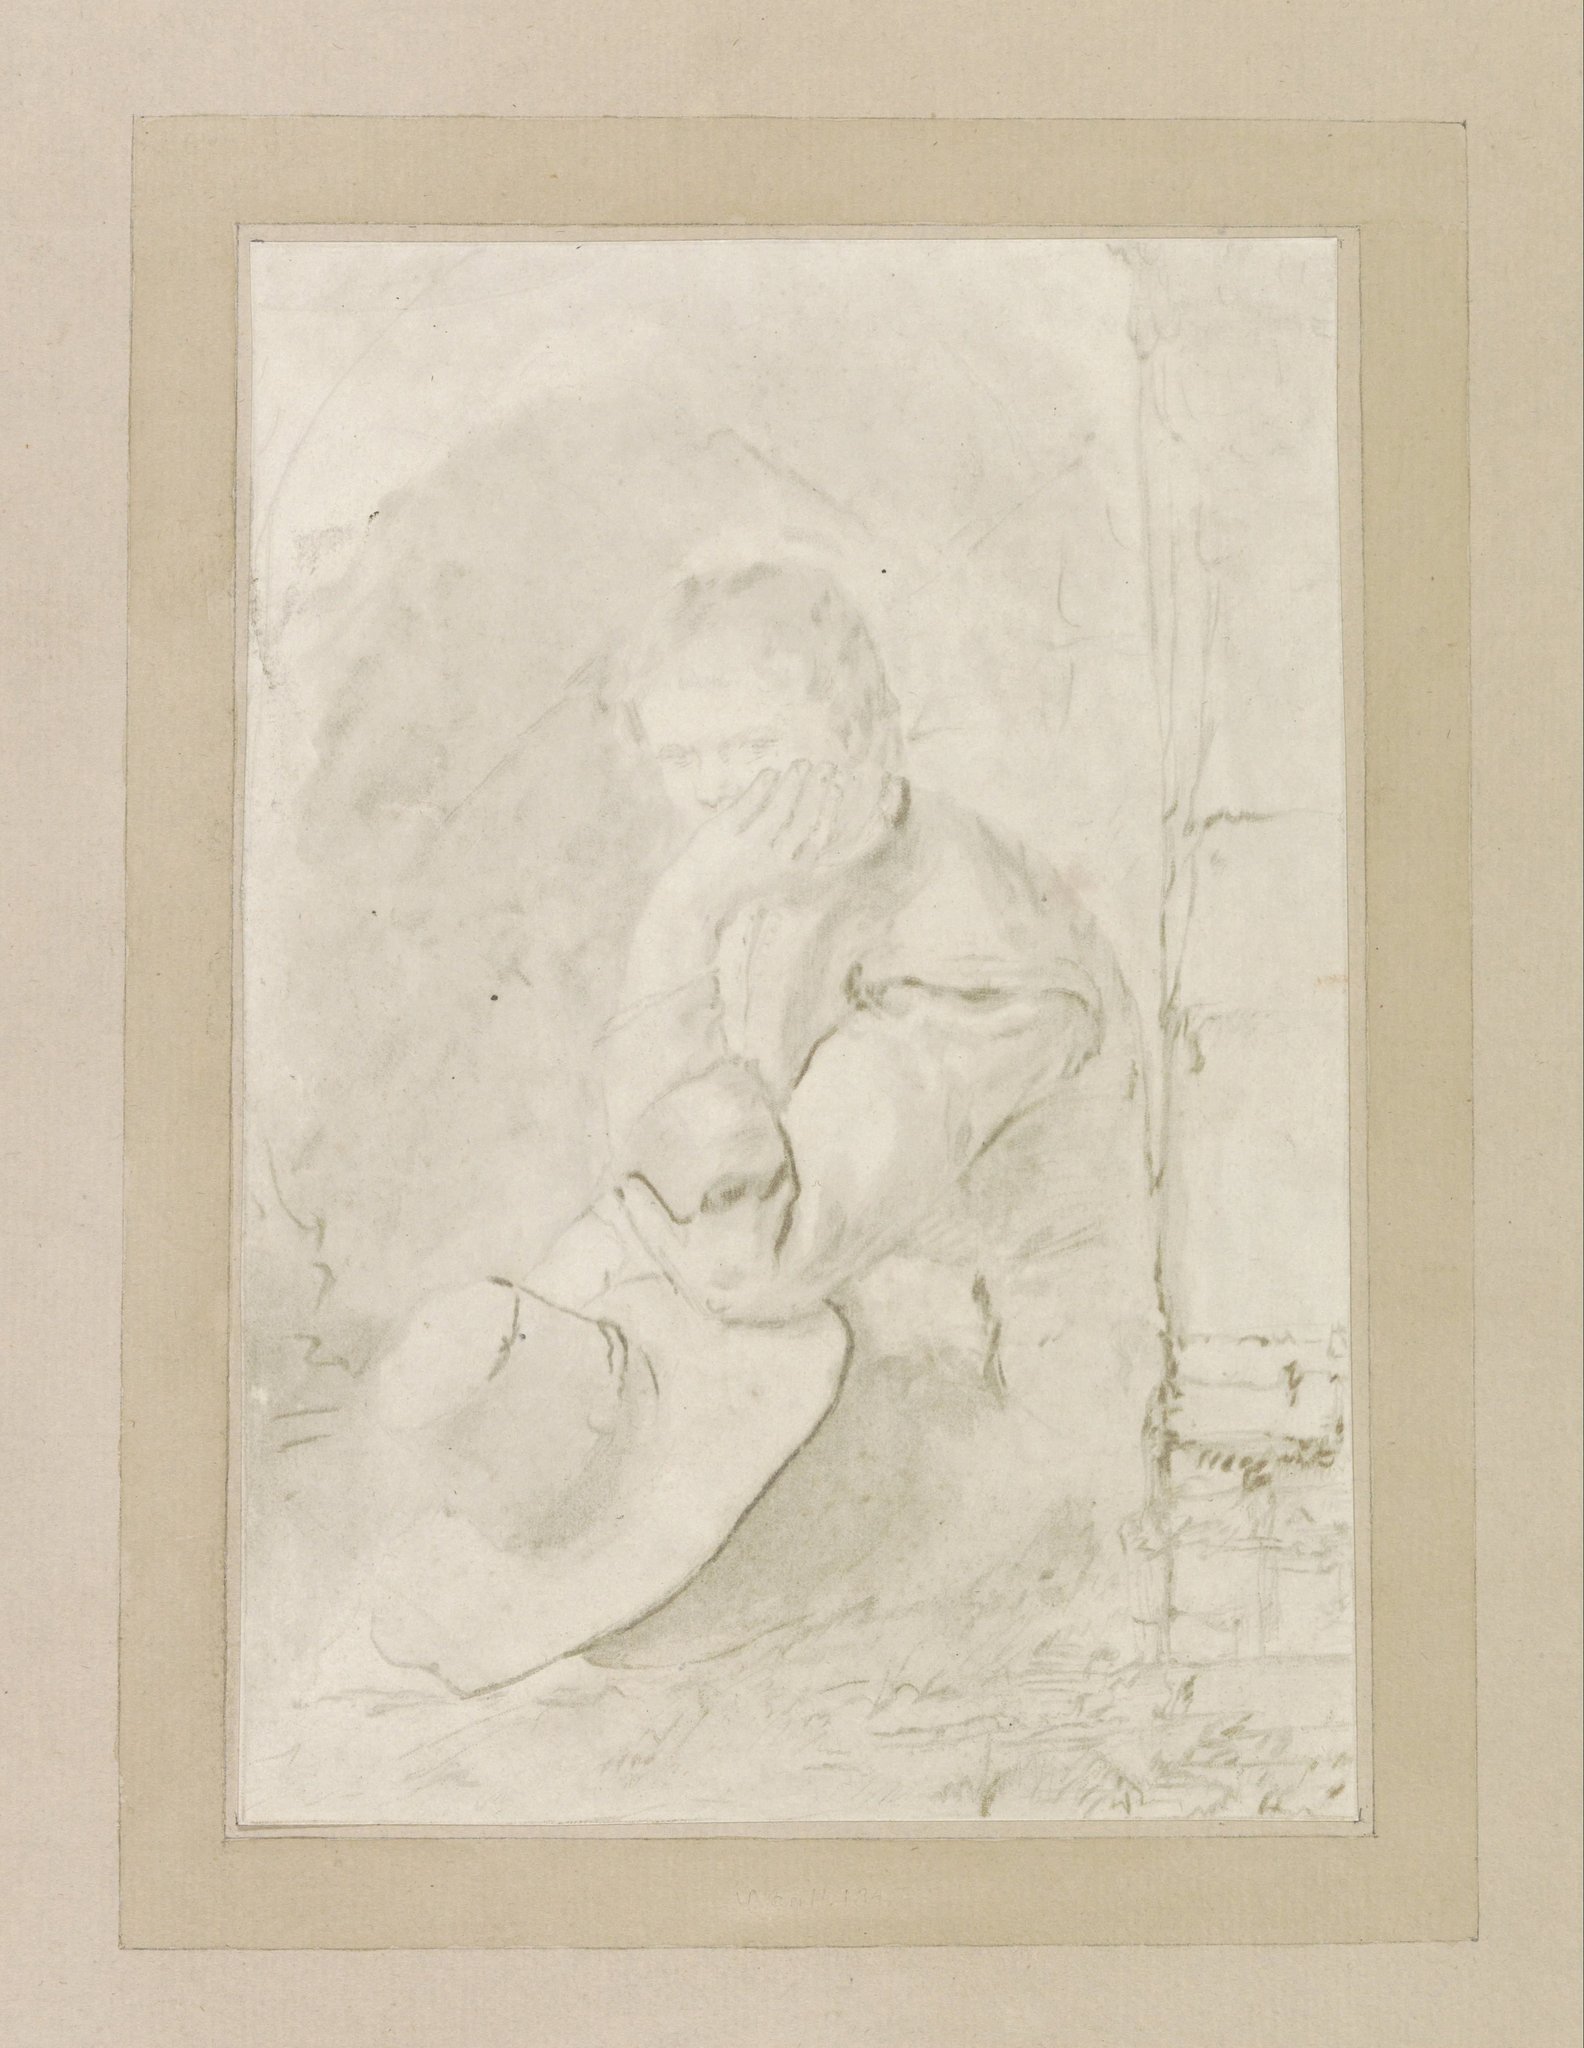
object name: print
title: Zittende man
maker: jurriaan cootwijck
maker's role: print maker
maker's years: 1714-1798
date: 1724-1798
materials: paper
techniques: hand coloring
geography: amsterdam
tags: sitting figure (+ adult male (human being))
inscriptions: collector's mark: Lugt 2228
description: De voltooide prent werd opgenomen in: Collection d'imitations de dessins d'après les principaux maîtres hollandais et flamands, Londen, C. Josi, 1821.